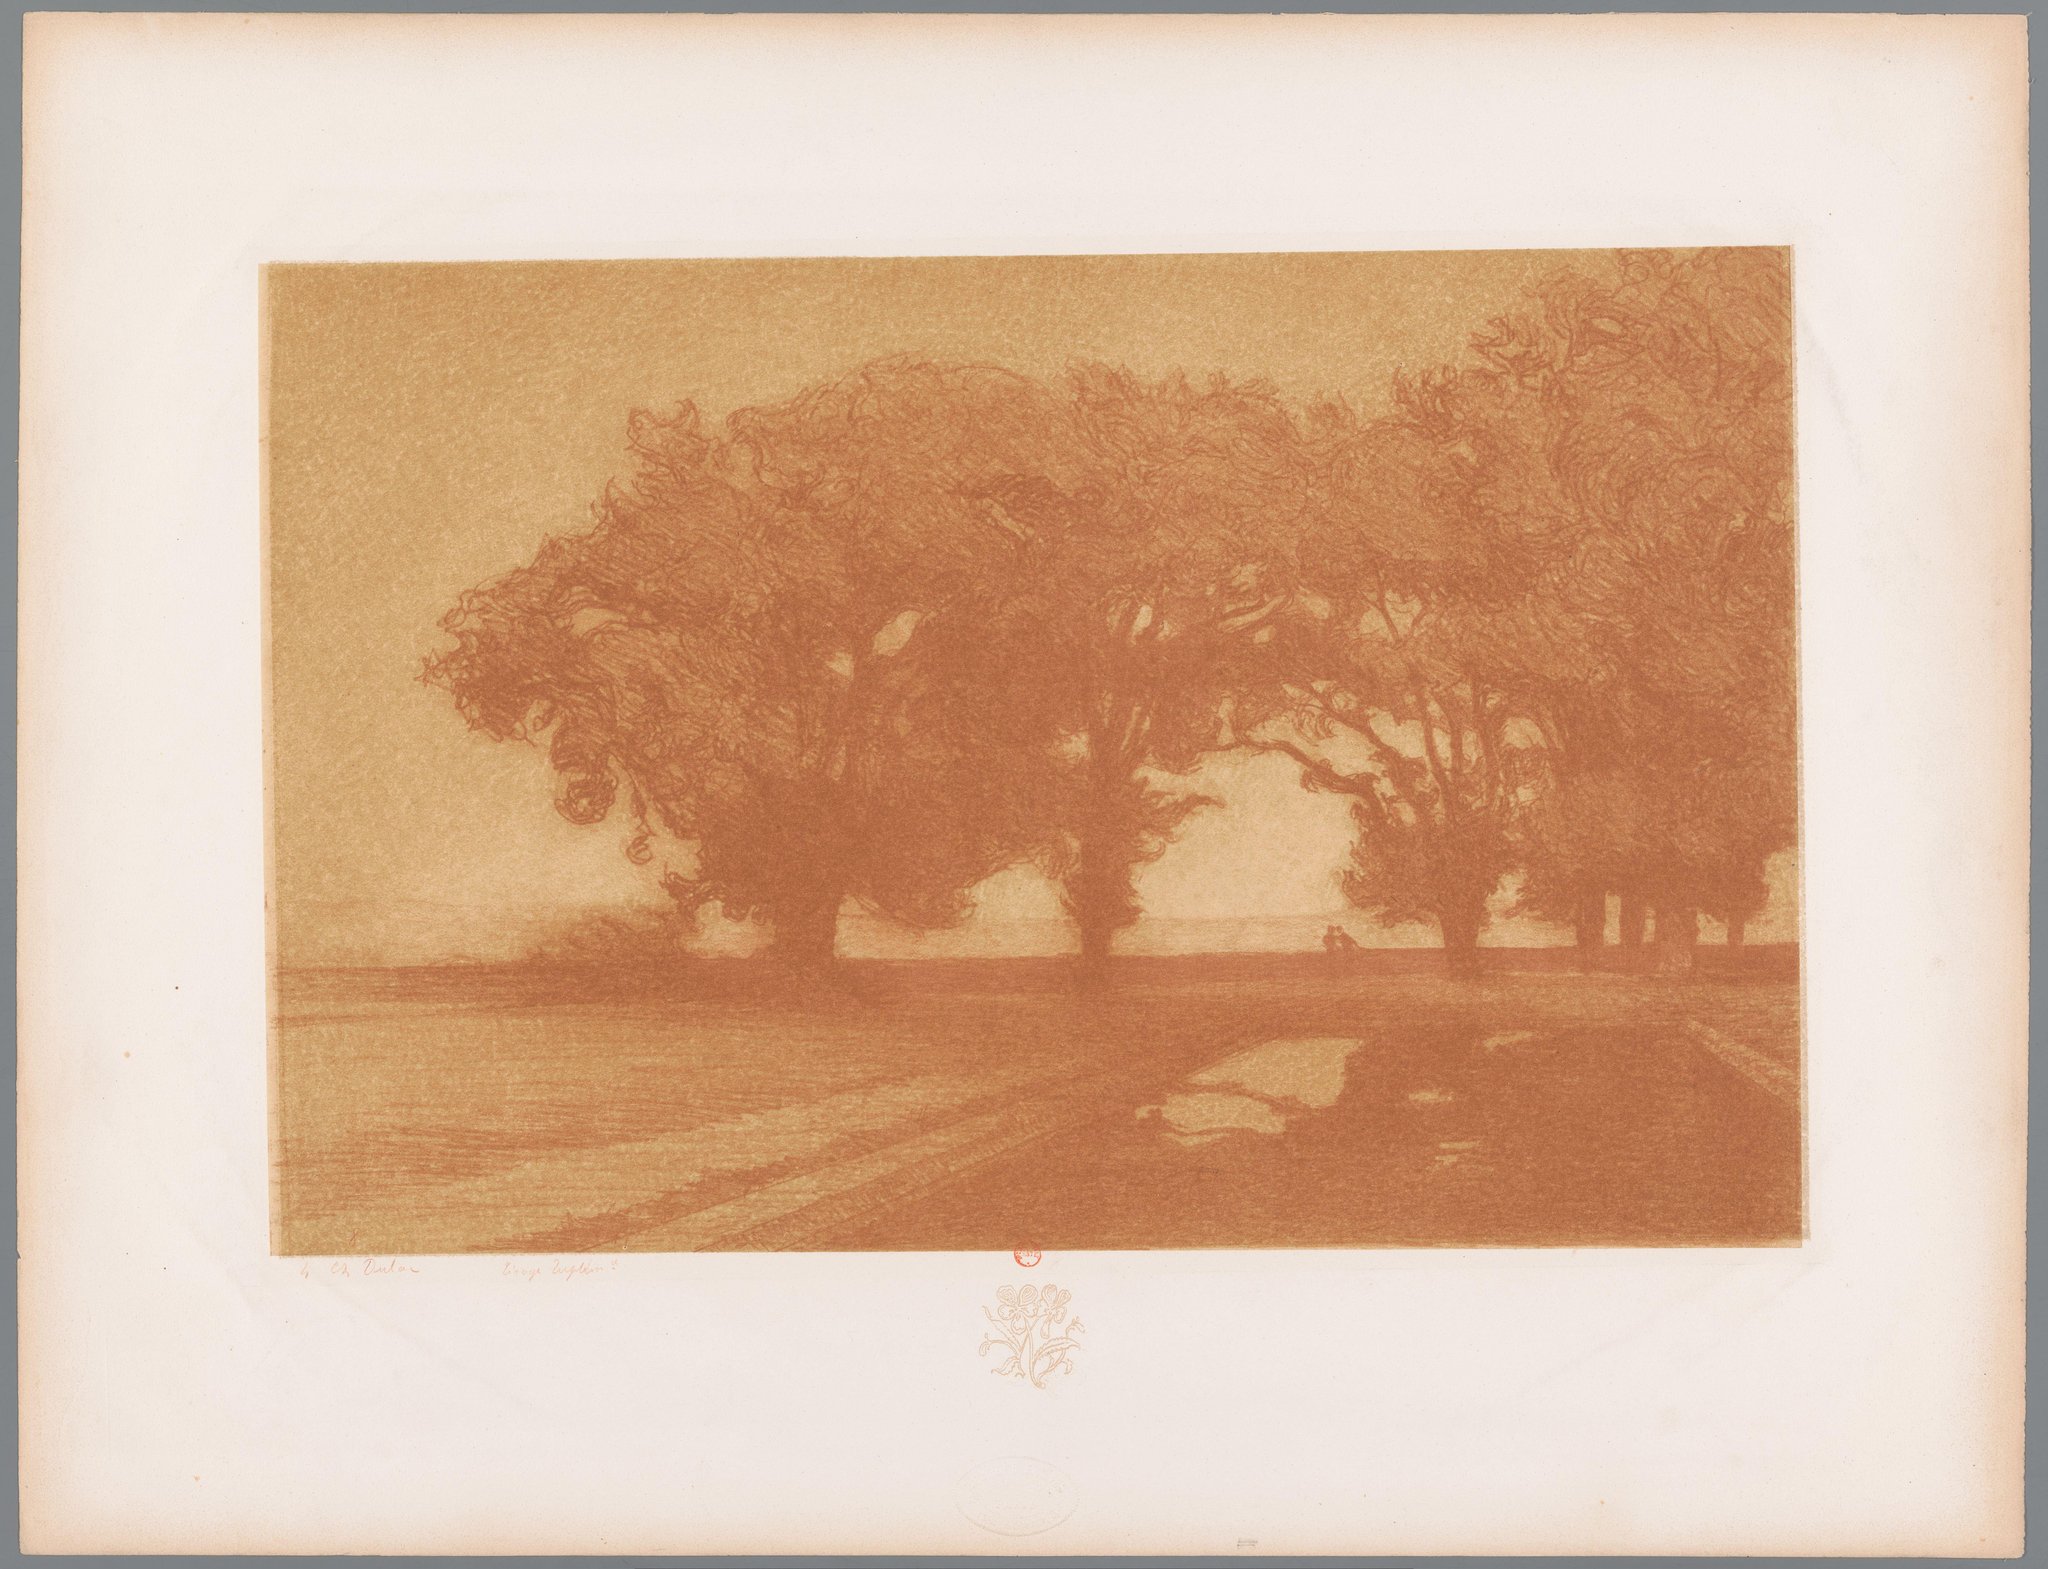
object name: print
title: Suite des Paysages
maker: charles marie dulac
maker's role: print maker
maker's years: 1865-1898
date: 1892-1893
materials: paper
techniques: lithography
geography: paris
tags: park, trees, pond, pool (+ landscape with figures, staffage)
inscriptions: collector's mark: Lugt 249, check stamp: ‘Monrocq Frères. Éditeurs, imprimeurs. 3, Rue Suger. Paris.’, collector's mark: Lugt 2228a, collector's mark: Lugt 2760, stamp: ‘B.N. éch. 1976’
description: Remarque in marge onderaan: twee viooltjes.